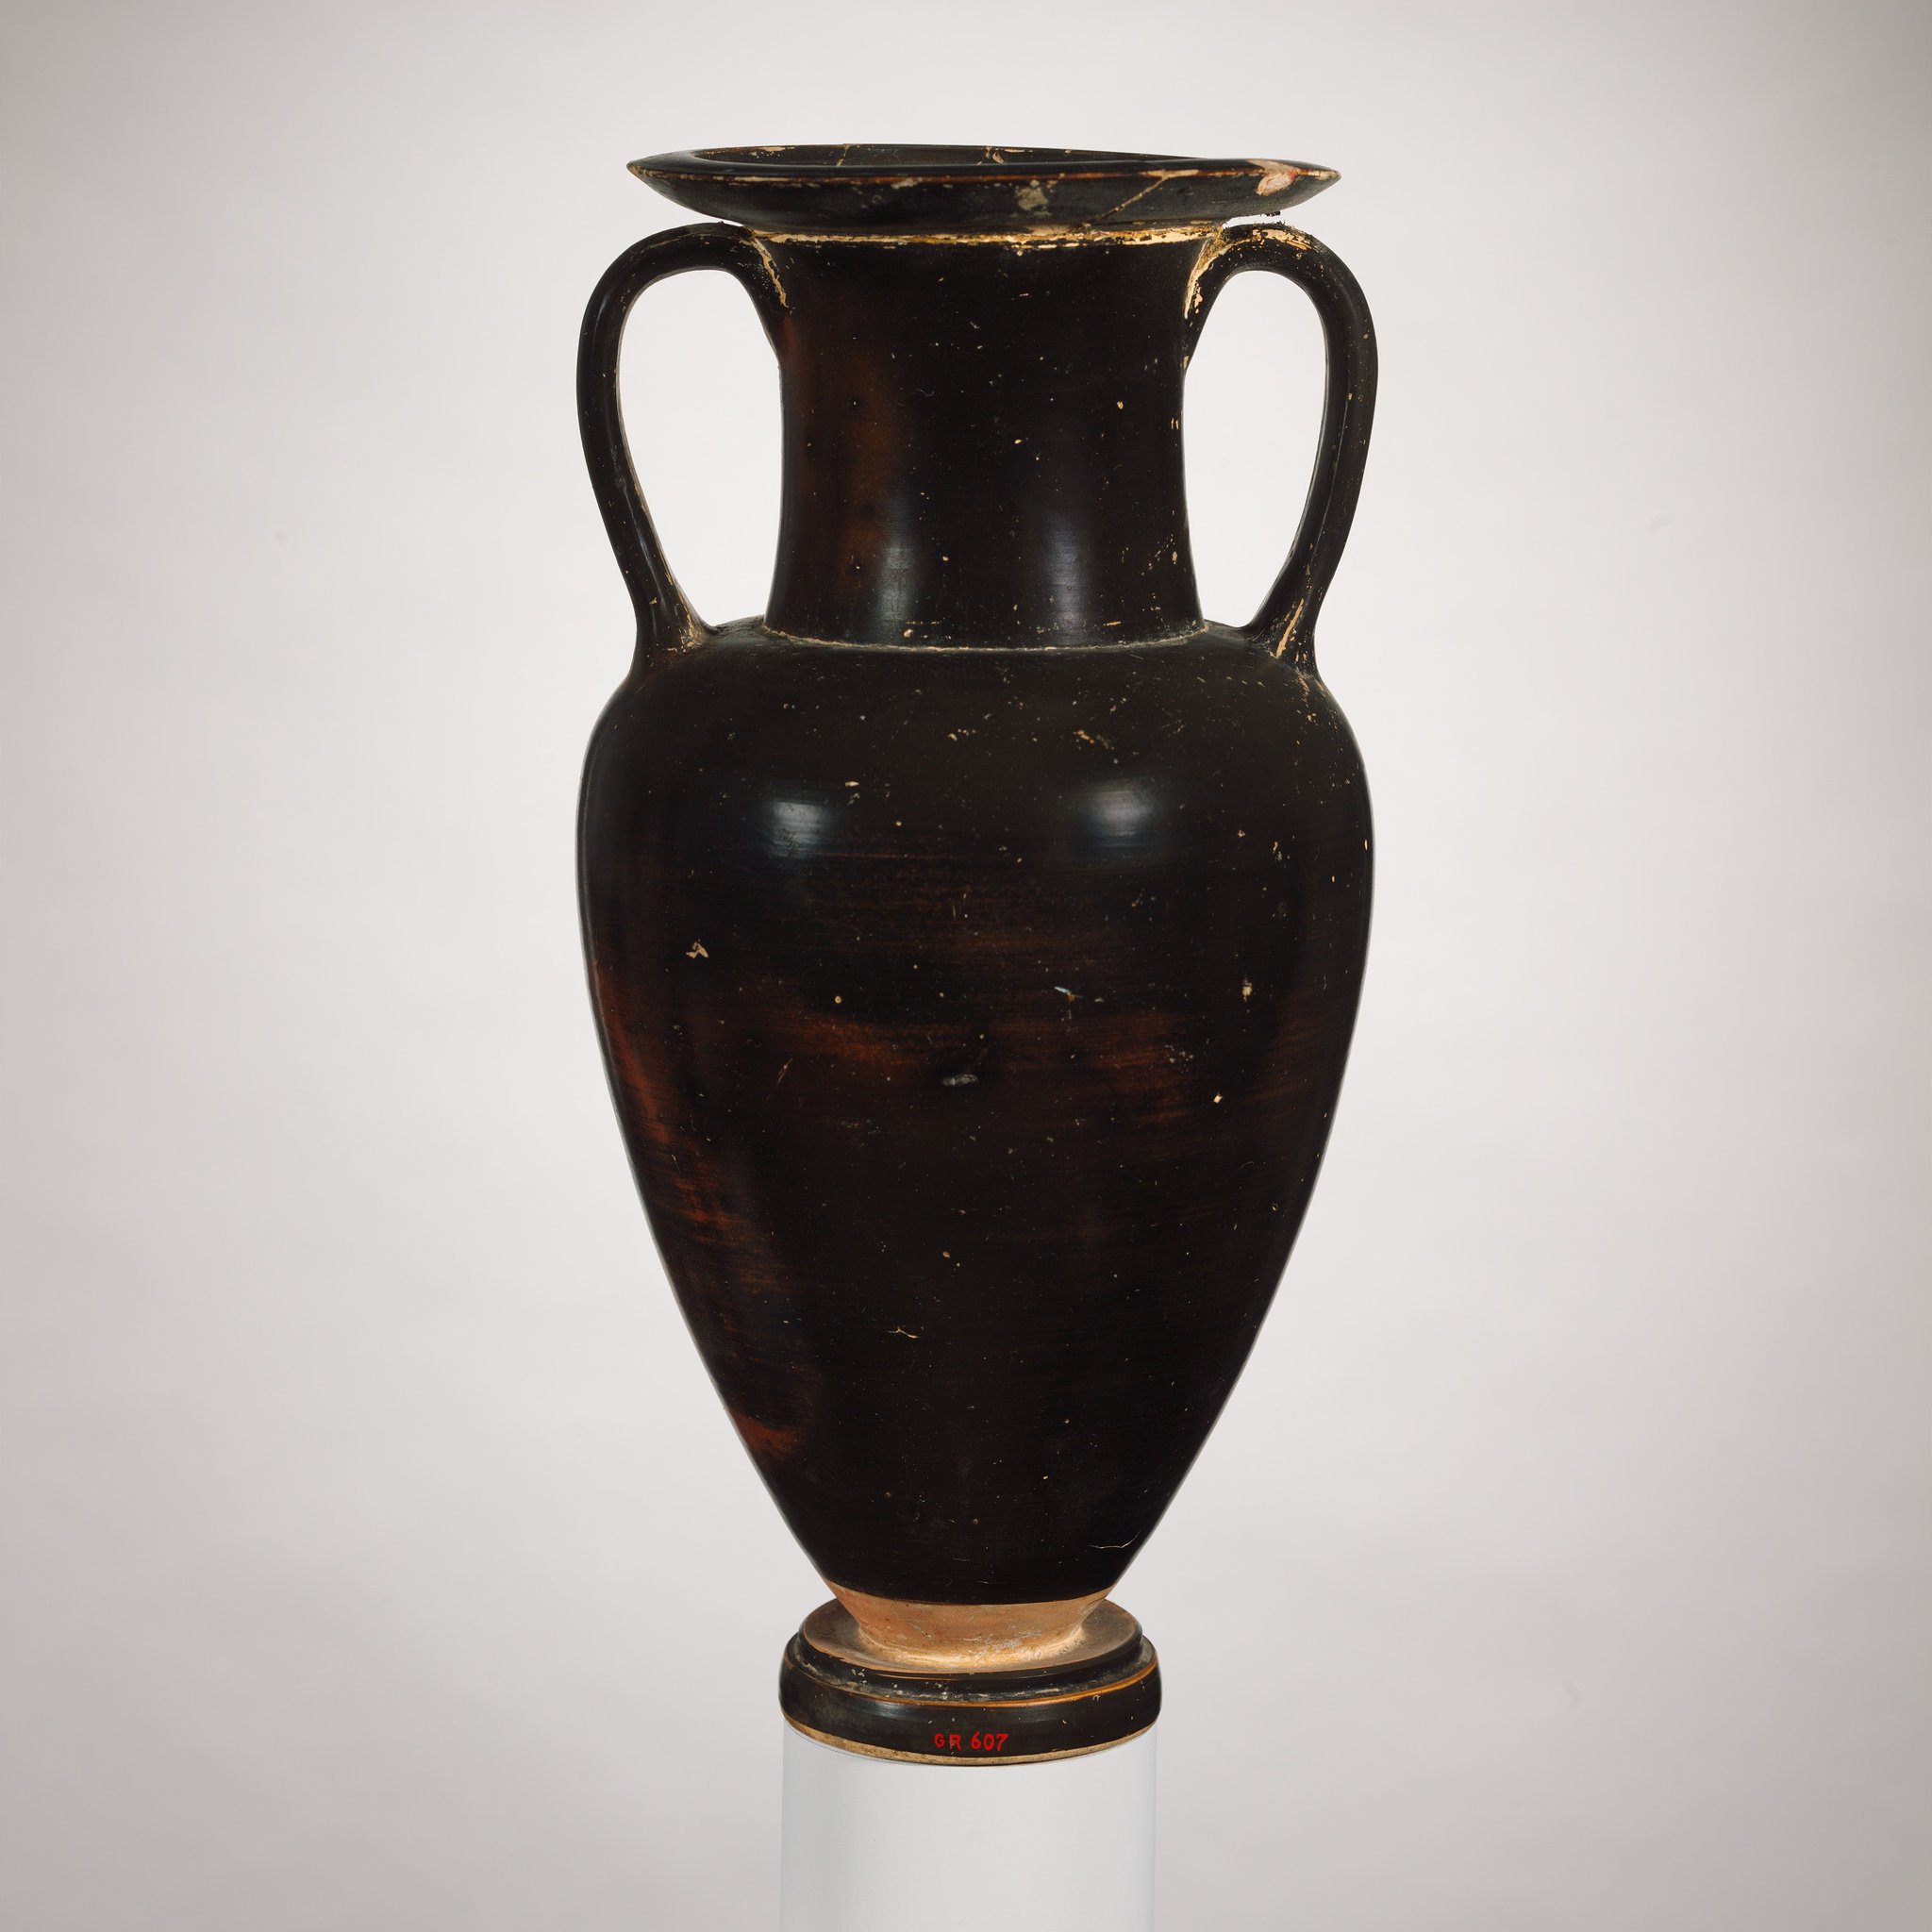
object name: neck amphora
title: Terracotta neck-amphora (jar)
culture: greek or south italian or campanian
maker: owl-pillar group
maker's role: artist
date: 434-401 BCE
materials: terracotta